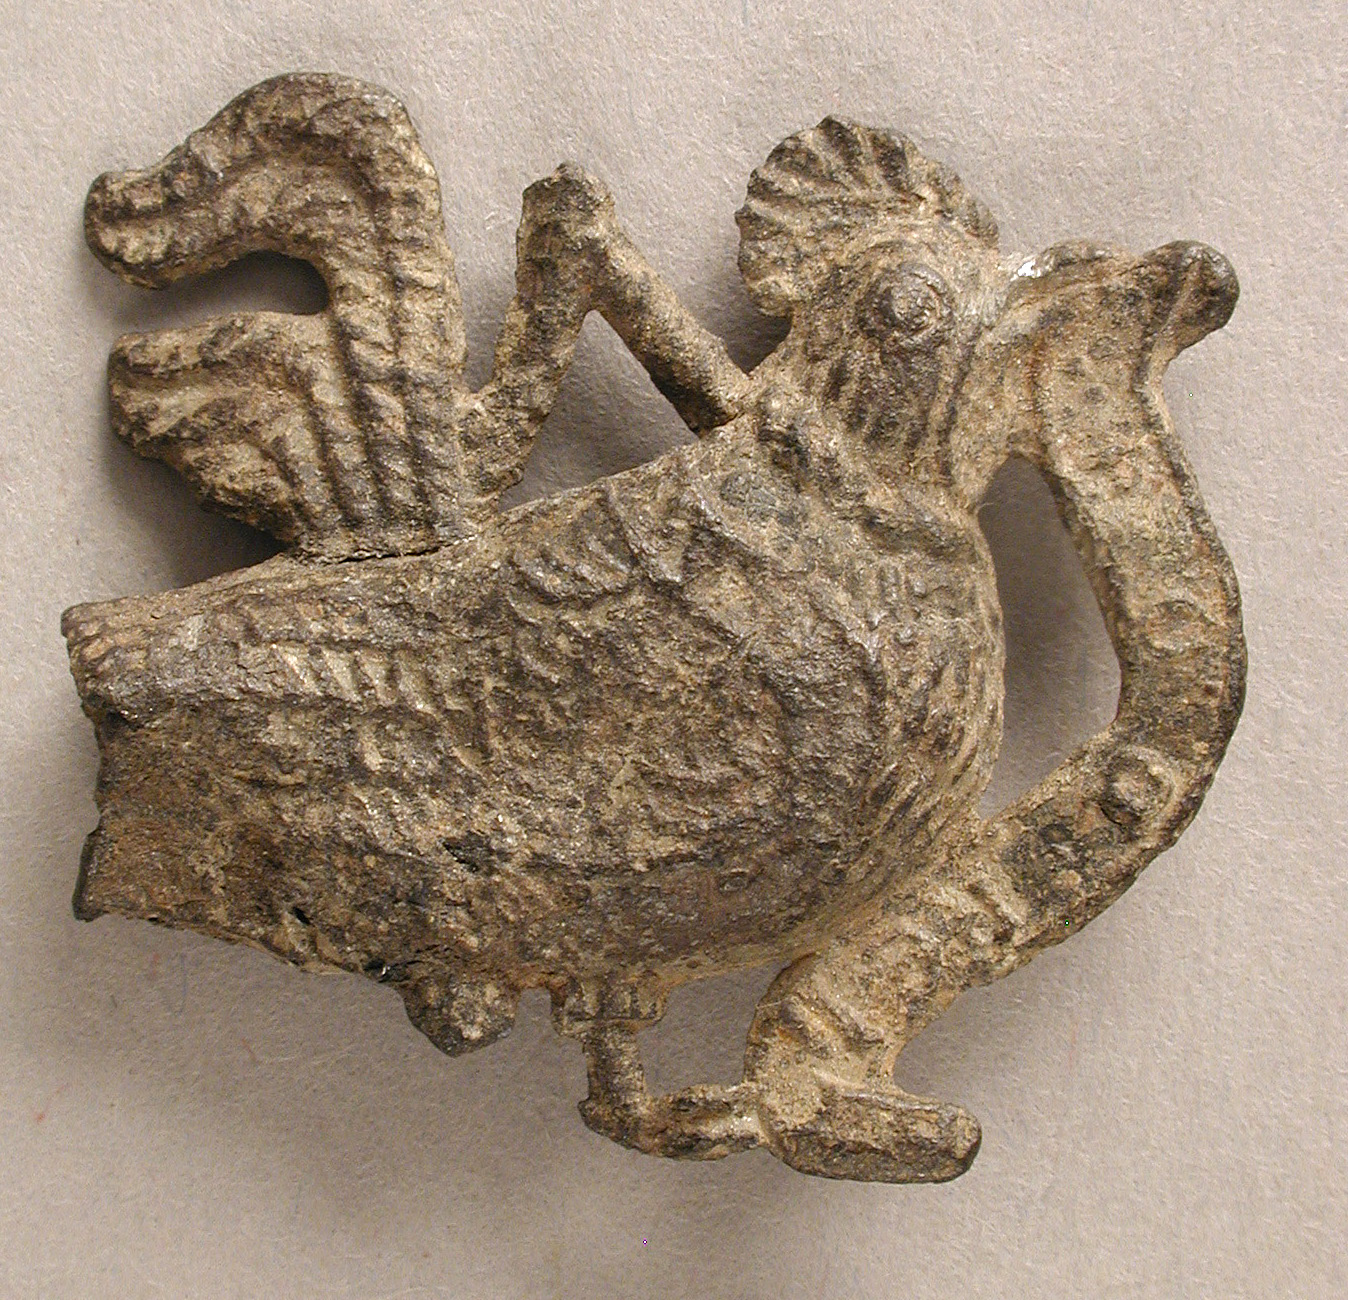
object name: pilgrim's badge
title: Badge with Cockney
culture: british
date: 1401-1500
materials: alloy, lead, tin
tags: roosters